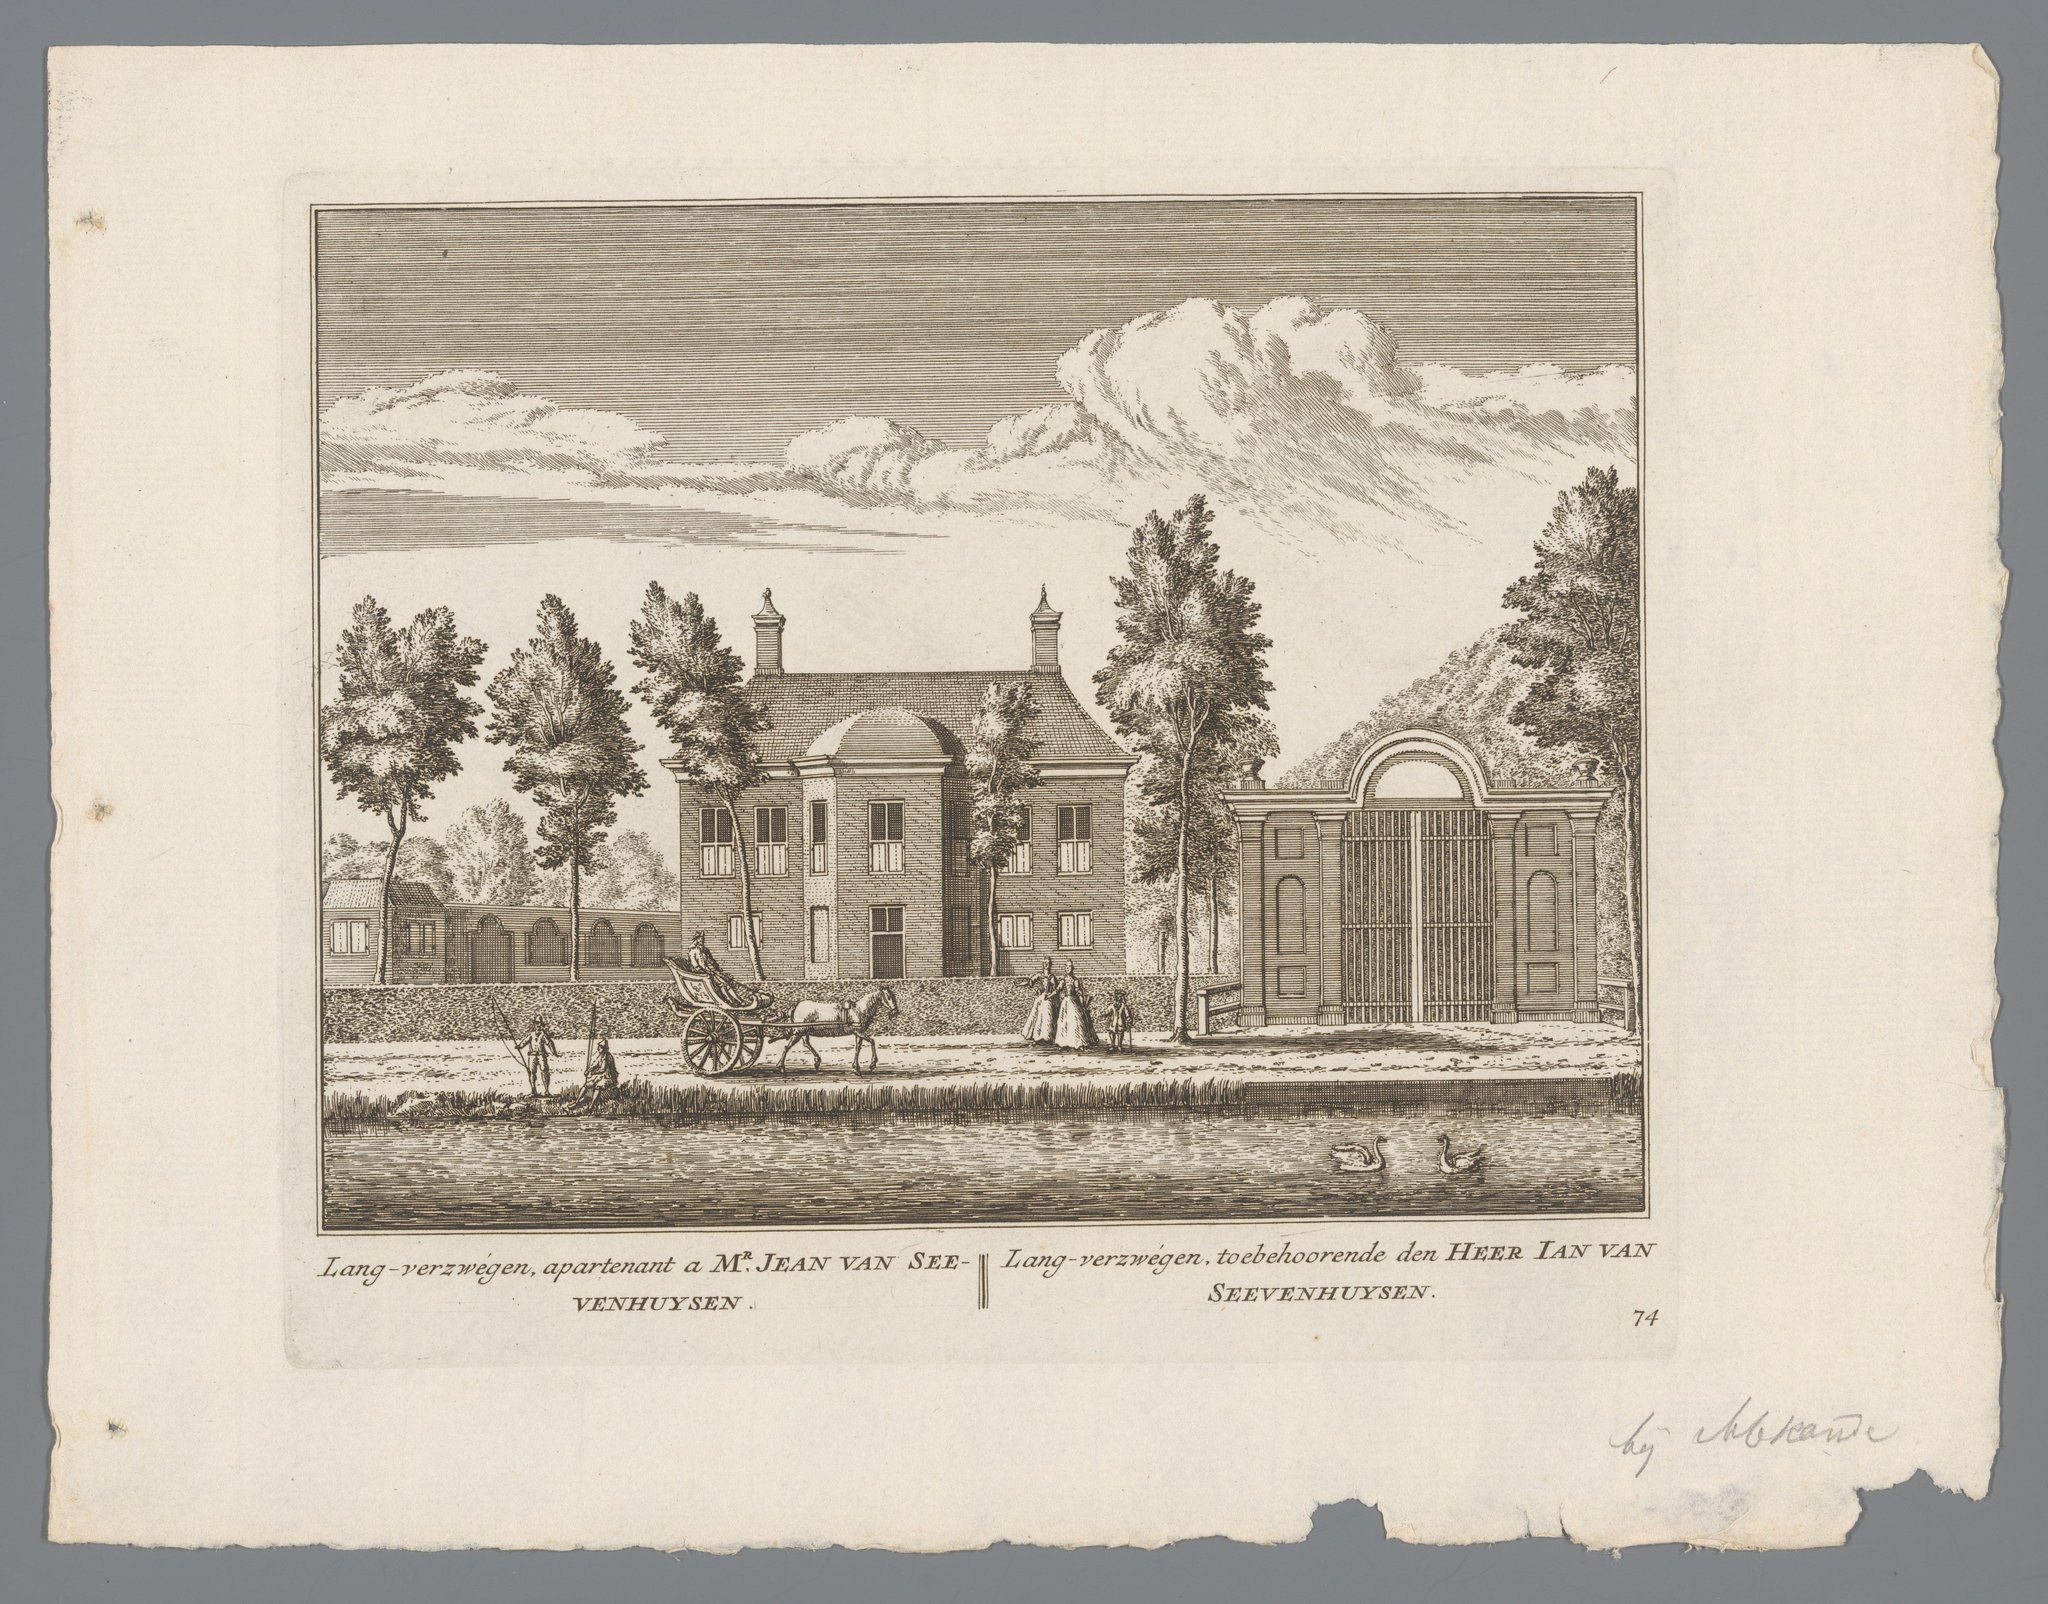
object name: book illustration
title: Lang-verzwégen, apartenant a mr. Jean van Seevenhuysen / Lang-verzwégen, toebehoorende den heer Ian van Seevenhuysen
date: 1730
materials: paper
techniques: etching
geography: amsterdam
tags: rural housing, e.g. country-house, villa, cottage, abcoude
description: Prent uit: Rademaker, Abraham. Hollands Arcadia, of de vermaarde rivier den Amstel (...) / L'Arcadie Hollandoise (...). Amsterdam: Leonard Schenk, 1730.